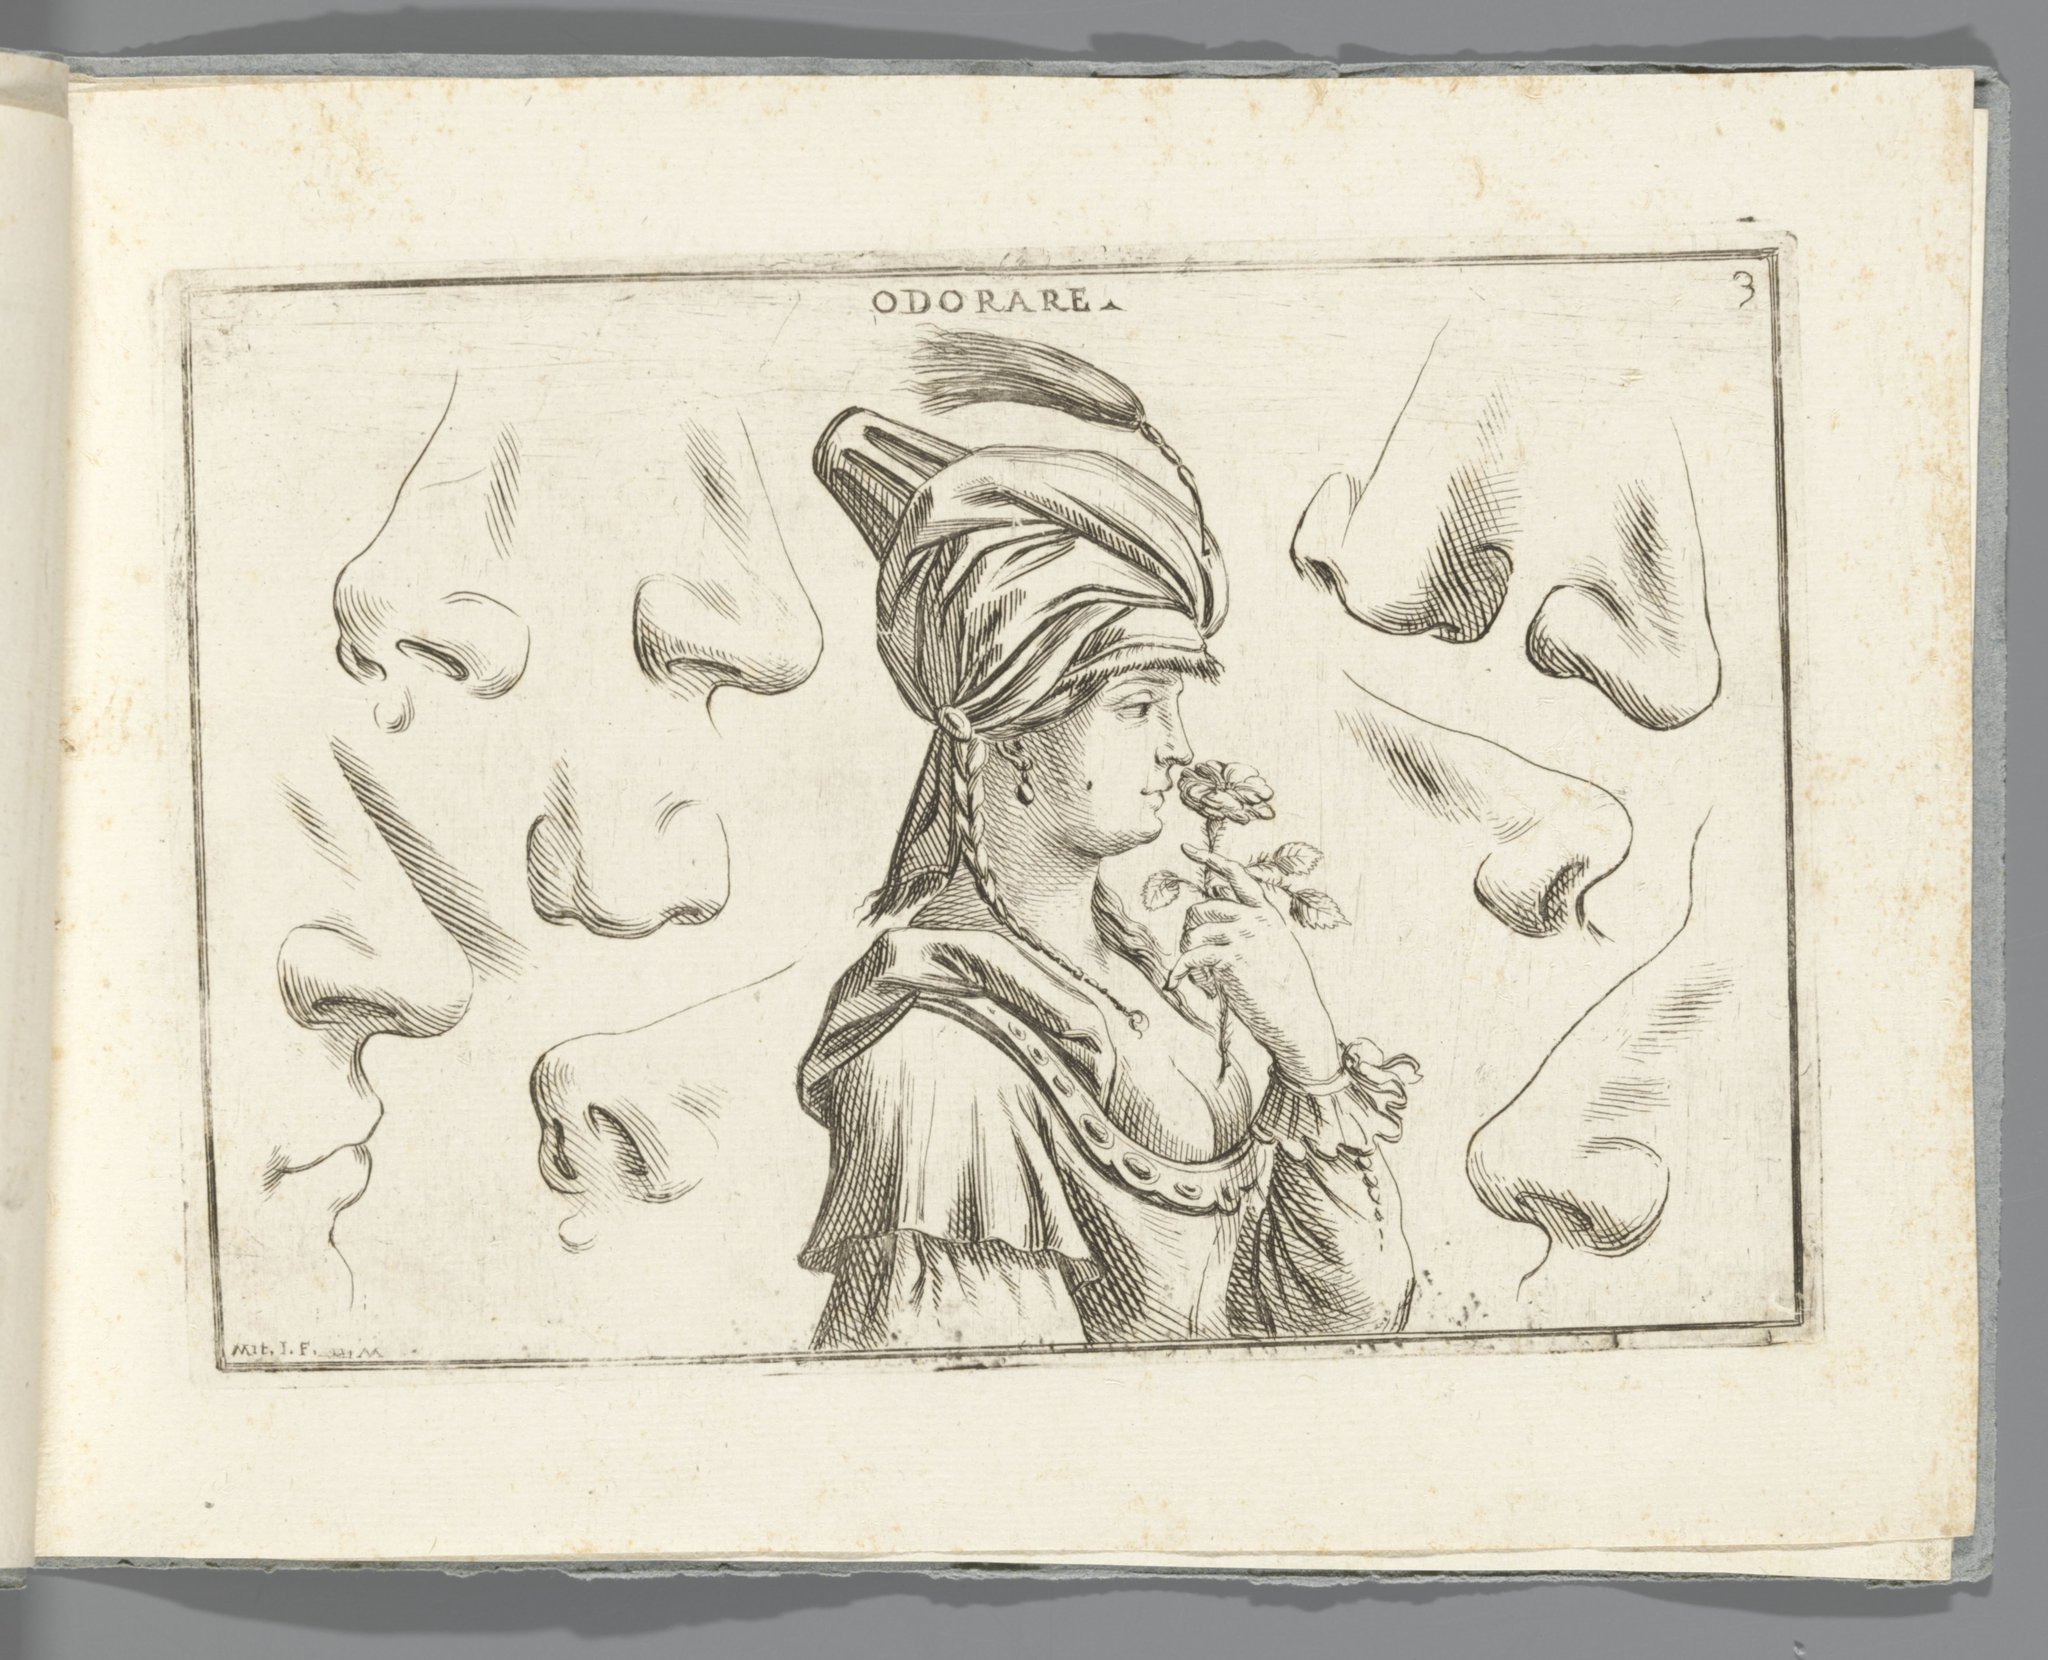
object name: print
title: Odorare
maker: giuseppe maria mitelli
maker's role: draughtsman, painter, print maker, publisher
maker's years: 1634-1718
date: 1700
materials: paper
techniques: etching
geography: italy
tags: smell, smelling (one of the five senses)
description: Prent uit tekenboekje opgebouwd rond de vijf zintuigen. Essemplare Per Disegnare Di Rame, nr. 12.Essemplare Per Disegnare Di Rame, nr. 12. Vijf prenten met tekenvoorbeelden opgebouwd rond personificaties van de vijf zintuigen gebonden in een 18de(?)-eeuws omslag van blauwgrijs papier.